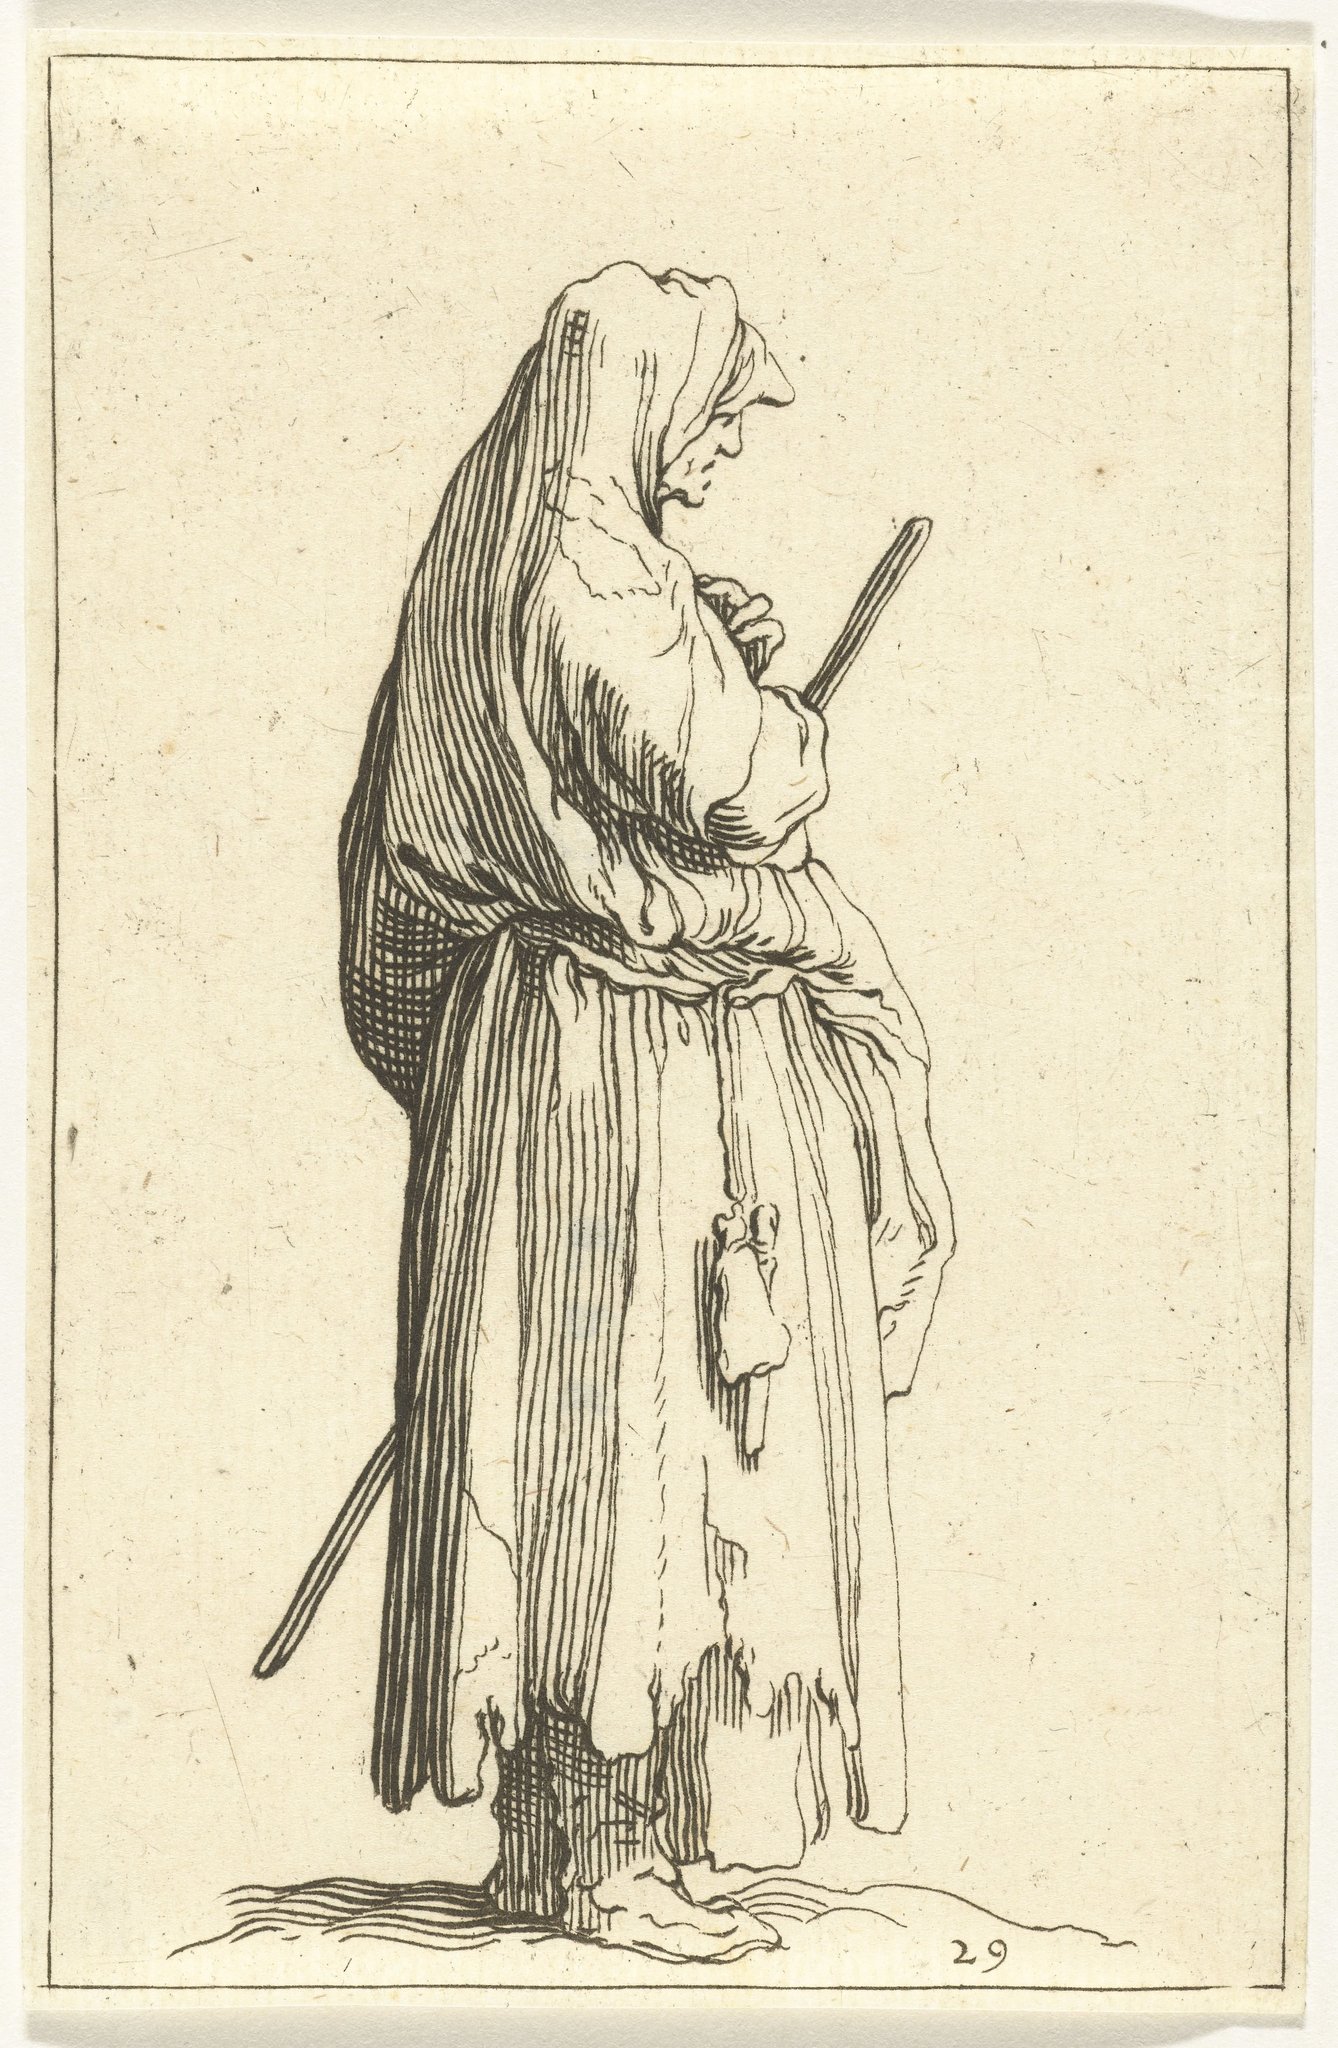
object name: print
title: De kleine figuren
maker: frederick bloemaert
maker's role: print maker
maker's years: 1614-1669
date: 1635-1669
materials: paper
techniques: engraving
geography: utrecht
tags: farmers - aa - female farmer, farmer's wife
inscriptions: collector's mark: Lugt 2233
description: Oude vrouw, zijwaarts afgebeeld, met stok en geldbuidel om haar middel.